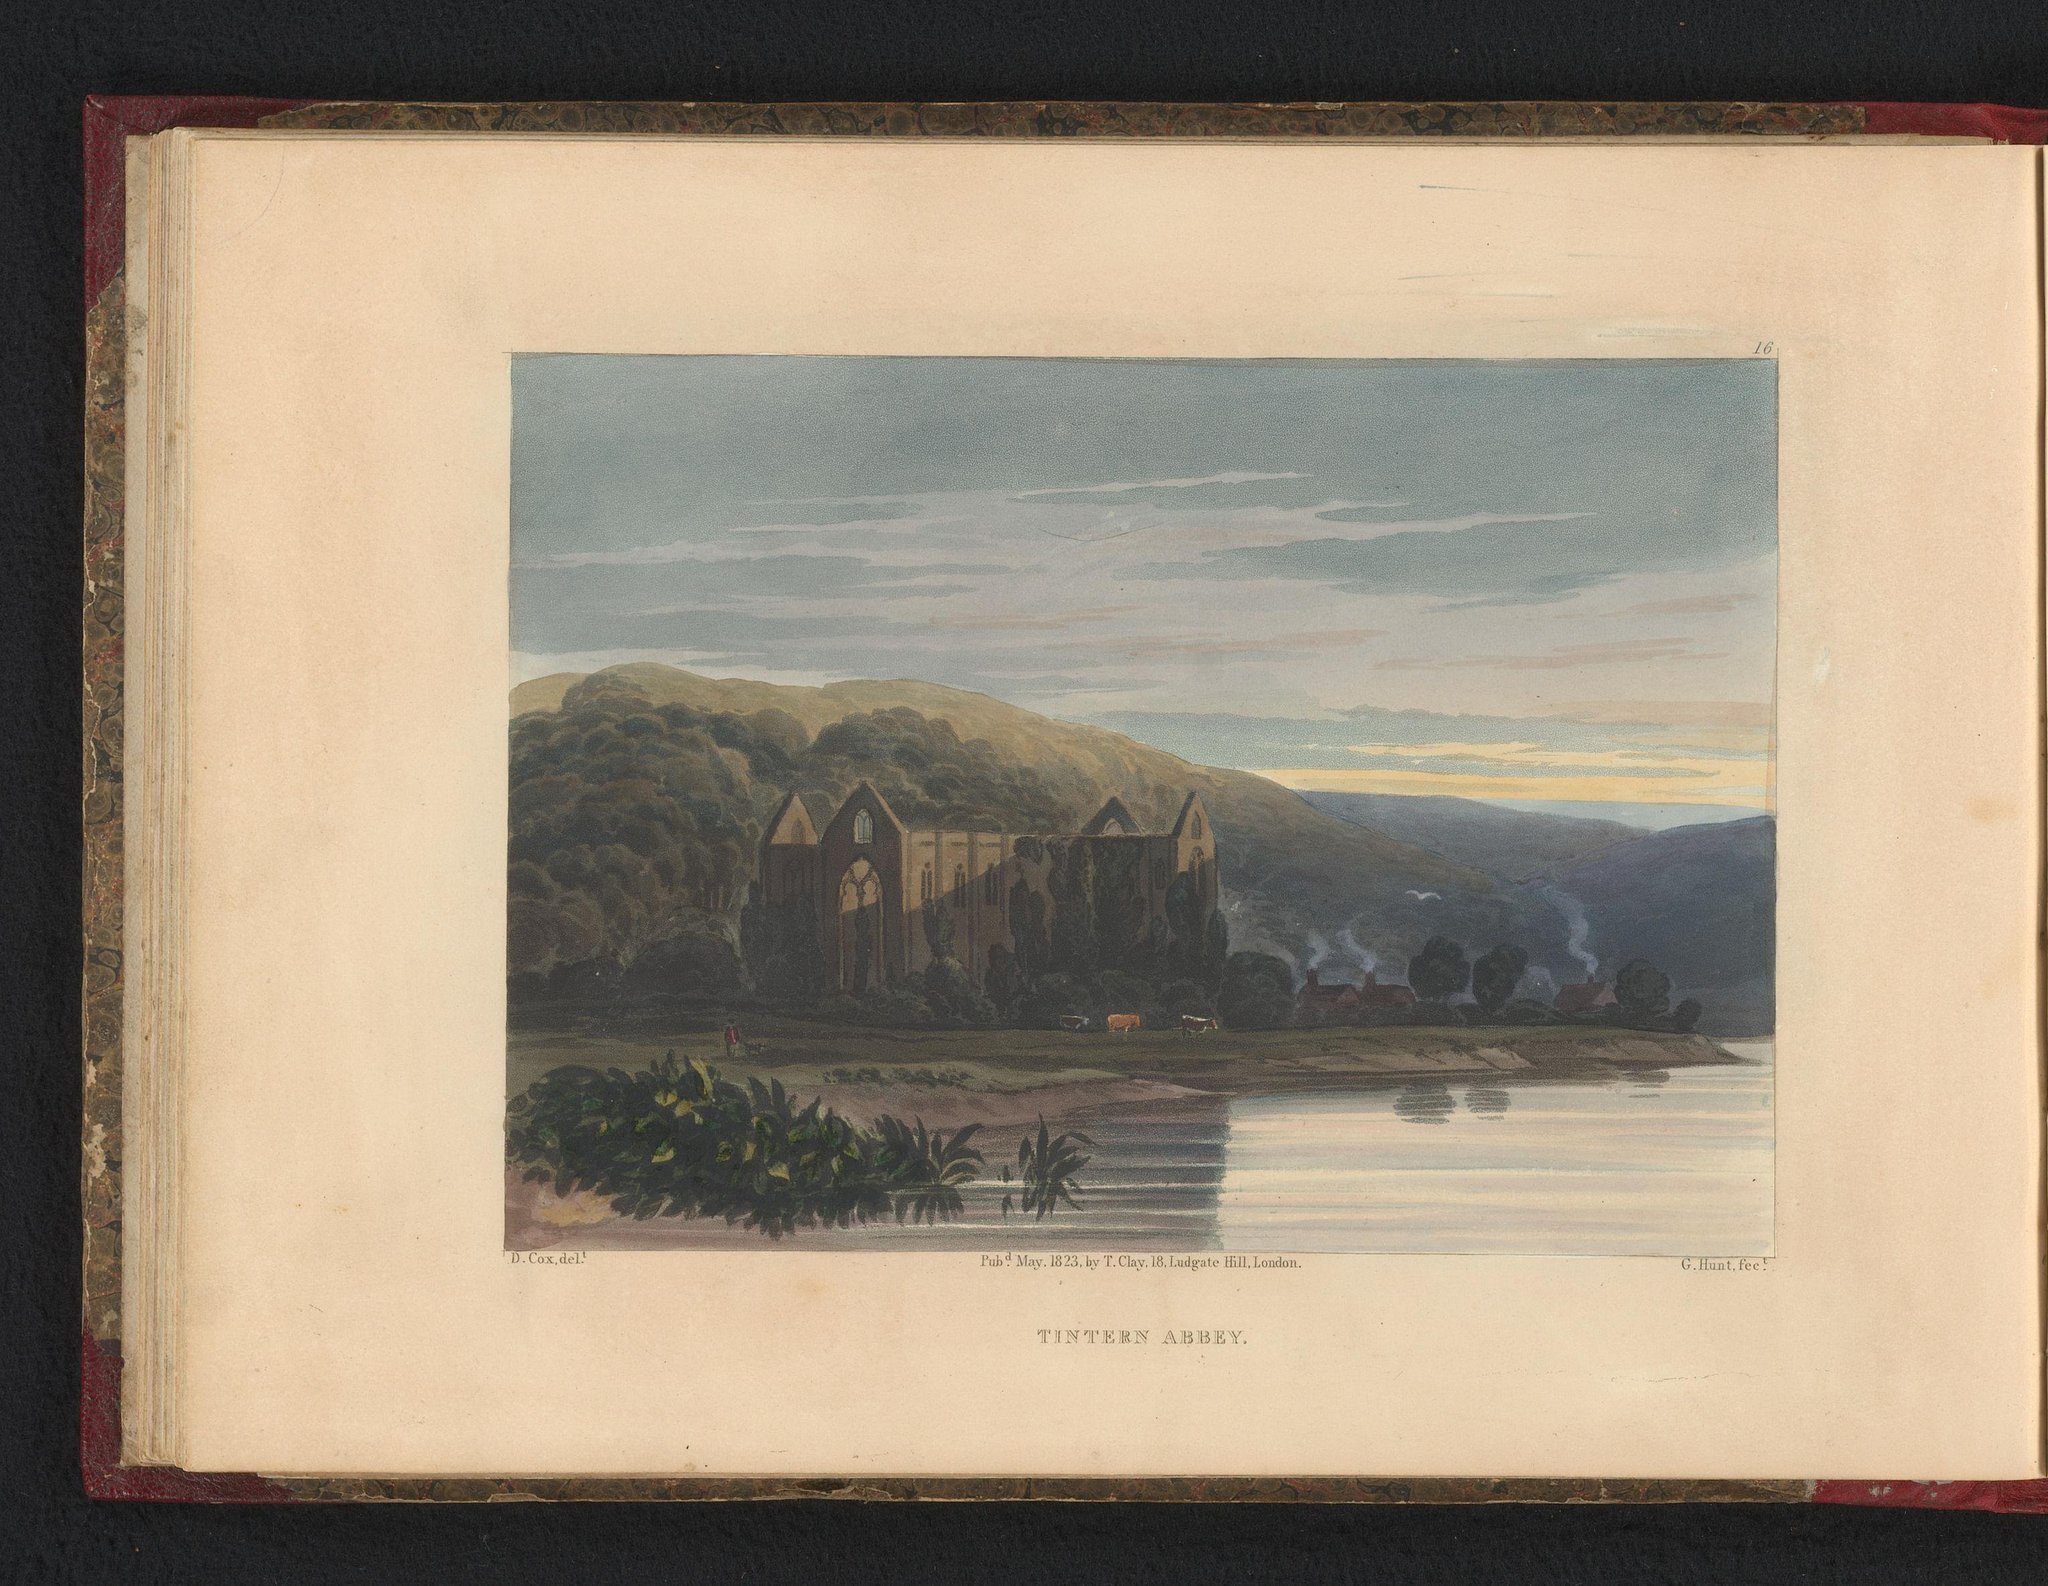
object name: page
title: Tintern Abbey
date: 1828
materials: paper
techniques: aquatint, hand coloring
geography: london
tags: abbey, monastery, convent ~ roman catholic church, painting (including book-illumination, miniature-painting)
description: Prent is gedrukt op de pagina tegenover pagina 27, waarop vier voorbeelden van kleuren met de hand zijn gekleurd.